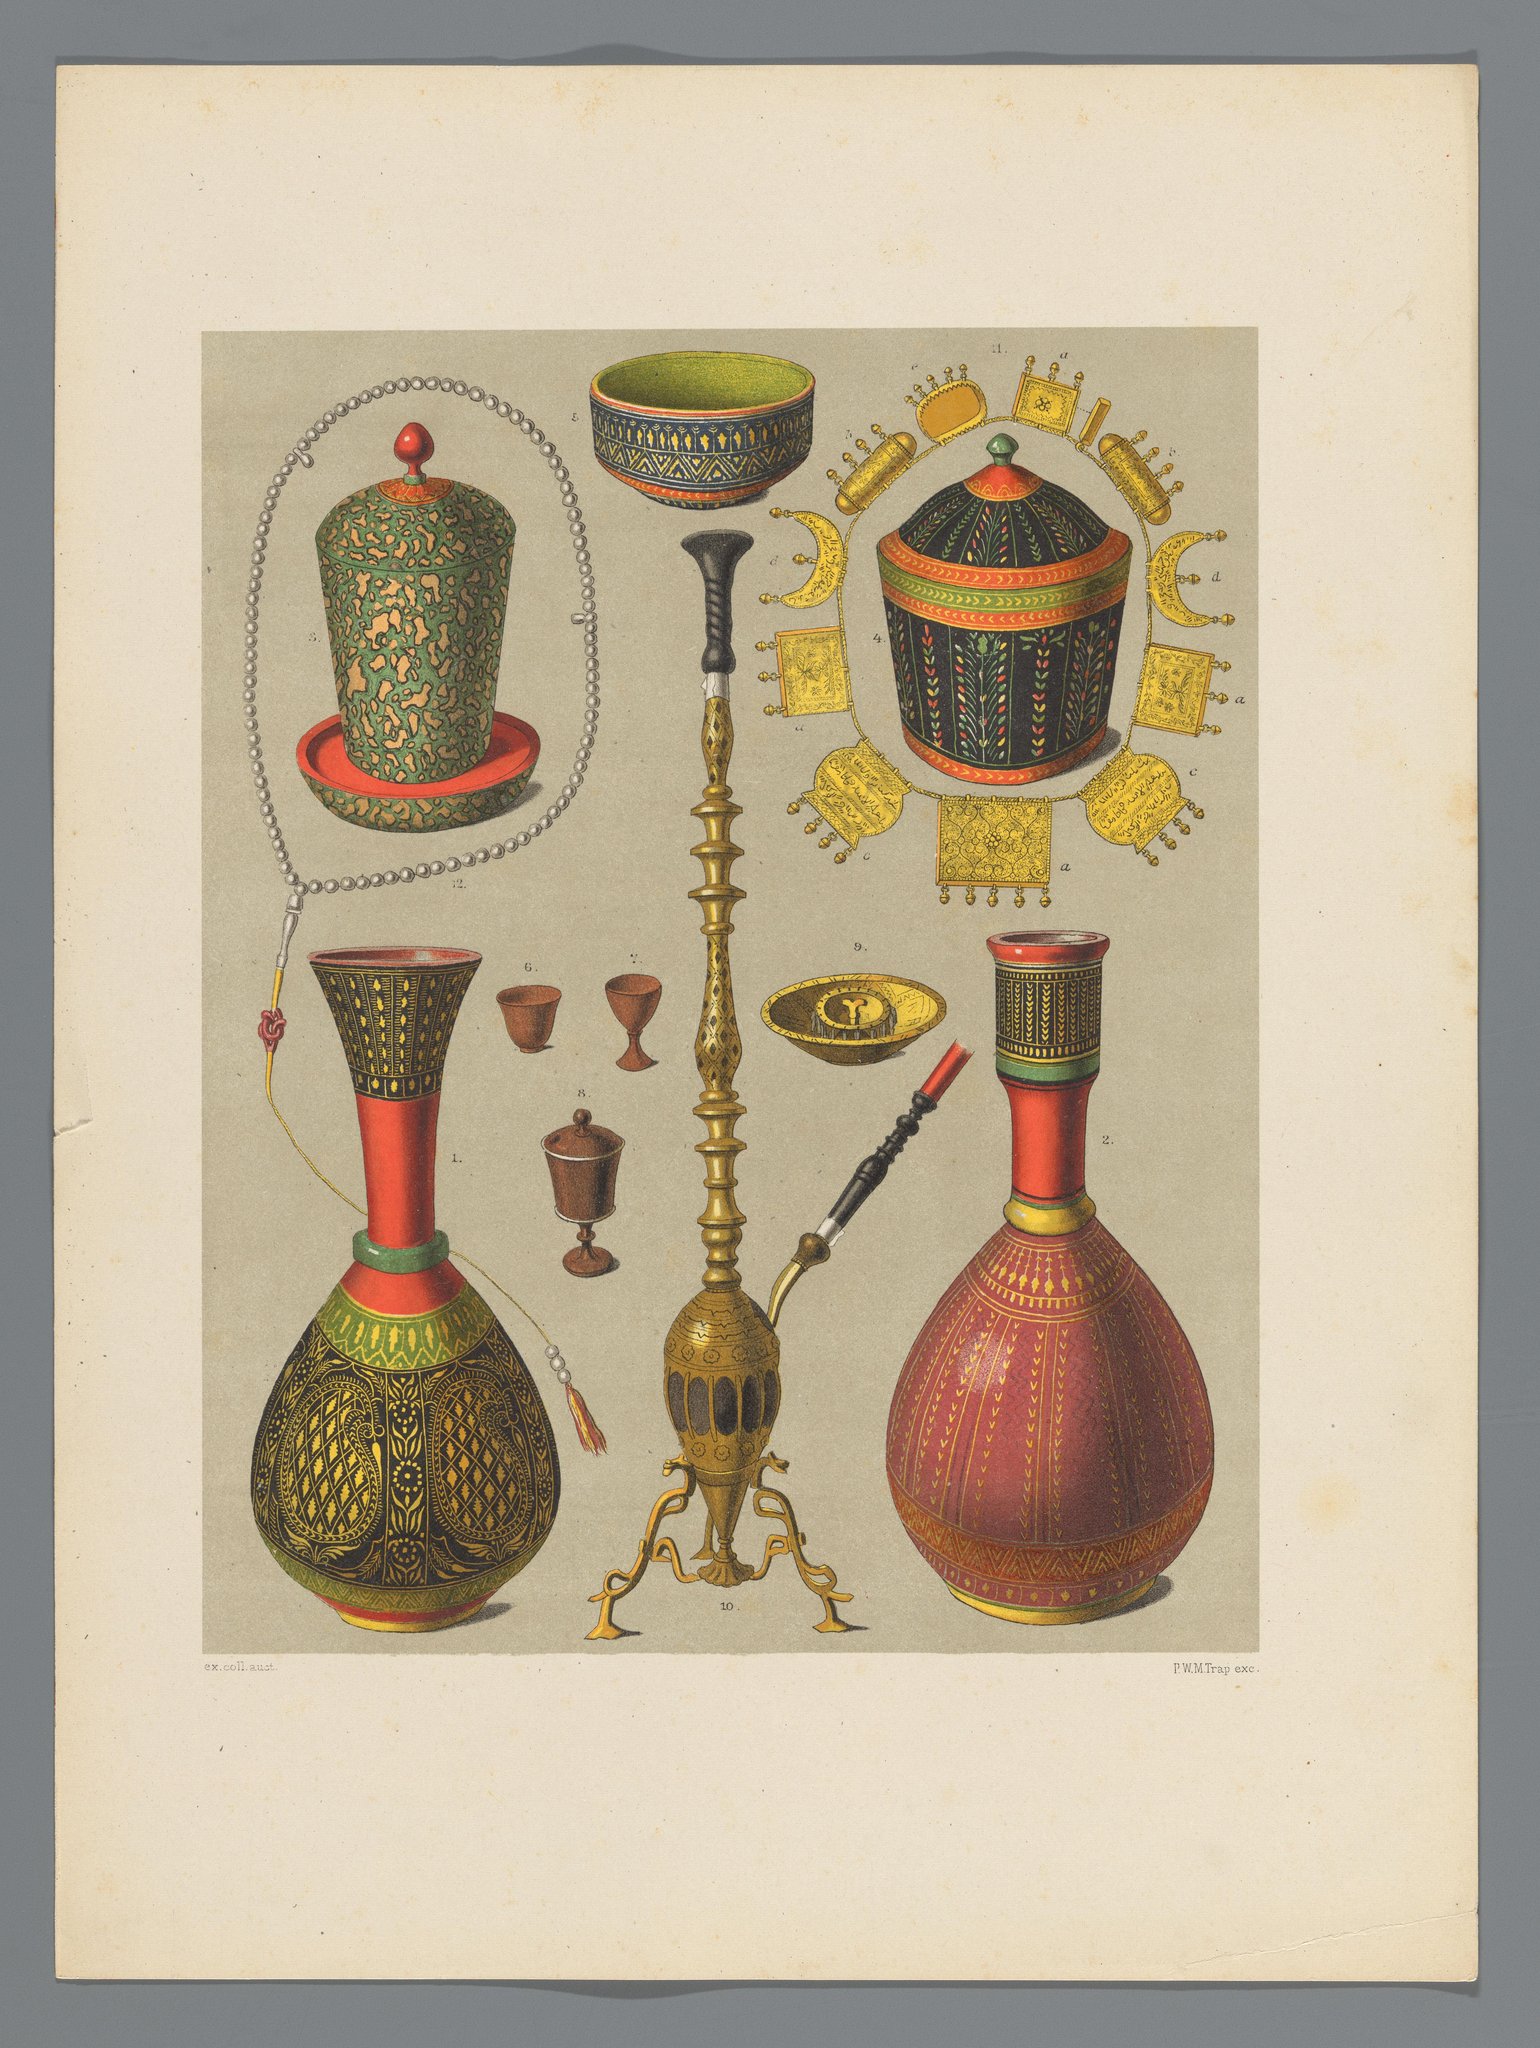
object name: page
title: Gebruiksvoorwerpen uit Mekka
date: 1883-1888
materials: paper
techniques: lithograph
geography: leiden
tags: still life of miscellaneous objects